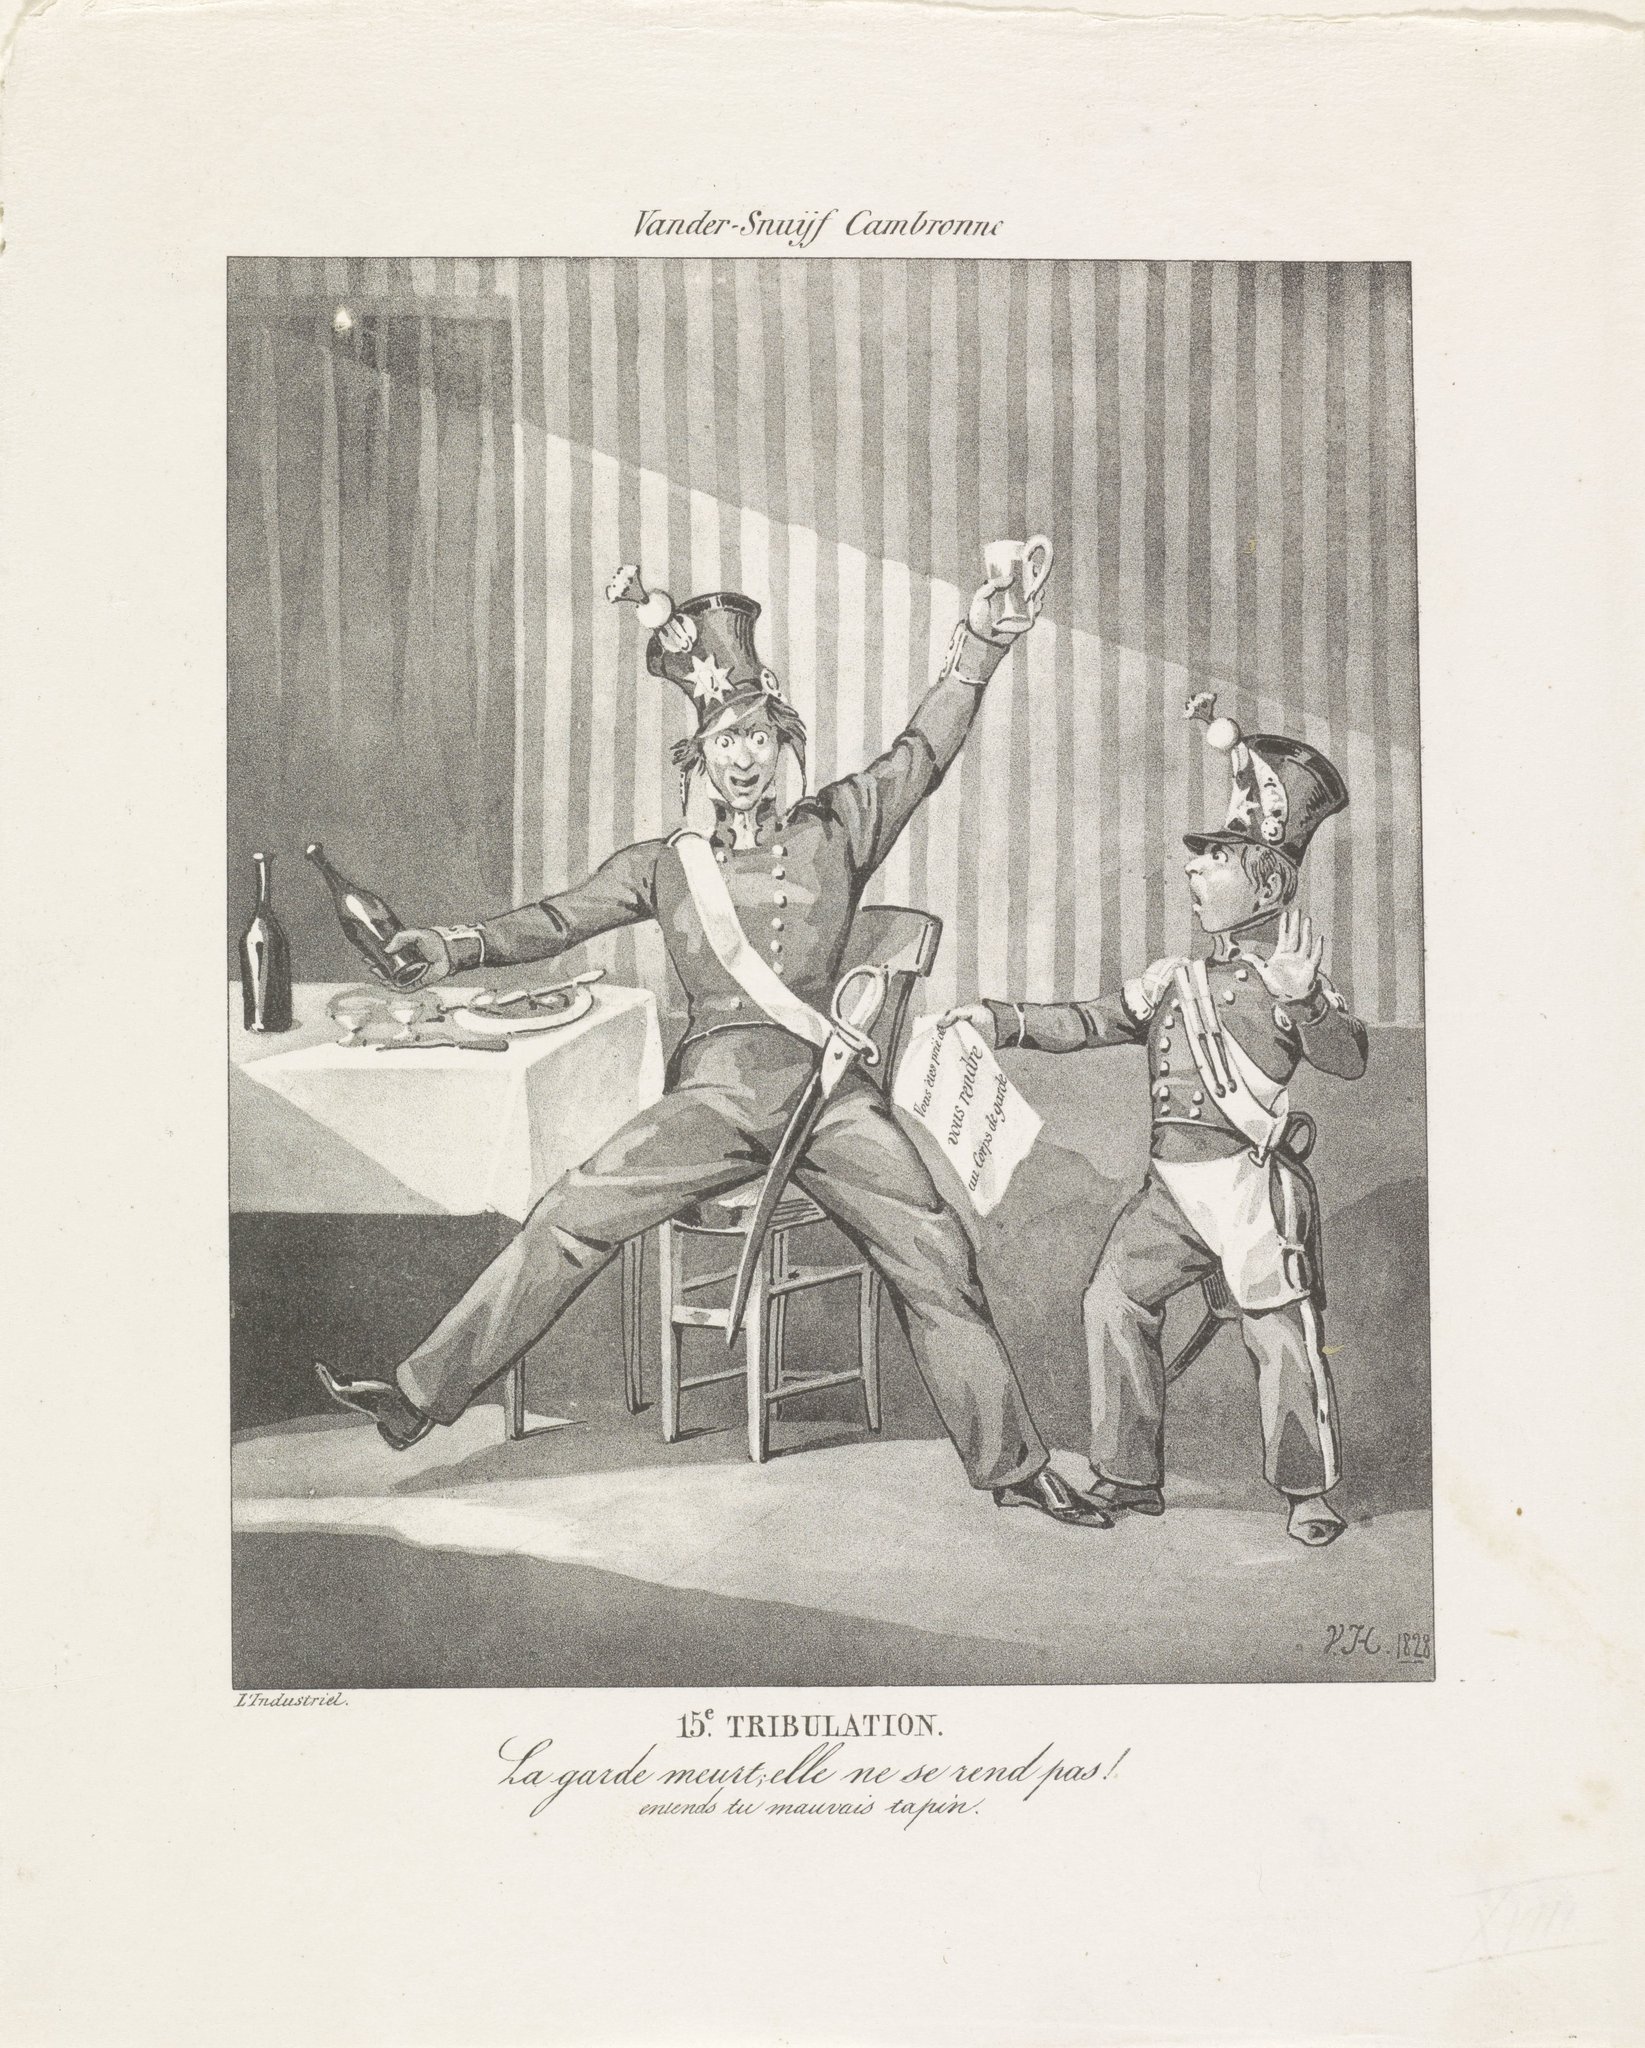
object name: print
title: Vijftiende beproeving, 1828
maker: jean-louis van hemelryck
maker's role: print maker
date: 1828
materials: paper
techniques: lithograph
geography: southern netherlands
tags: drunkenness, the soldier; the soldier's life, belgium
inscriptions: collector's mark: Lugt 2228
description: Van der Snuijff is dronken in een kroeg en krijgt van een boodschapper de order om terug te keren naar zijn korps. Onderdeel van een serie van ca. 24 spotprenten uit 1828 op de wanverhoudingen binnen de Belgische schutterijen door de maatschappelijke ongelijkheid binnen het korps, na de reorganisatie ingevoerd op 11 april 1827.